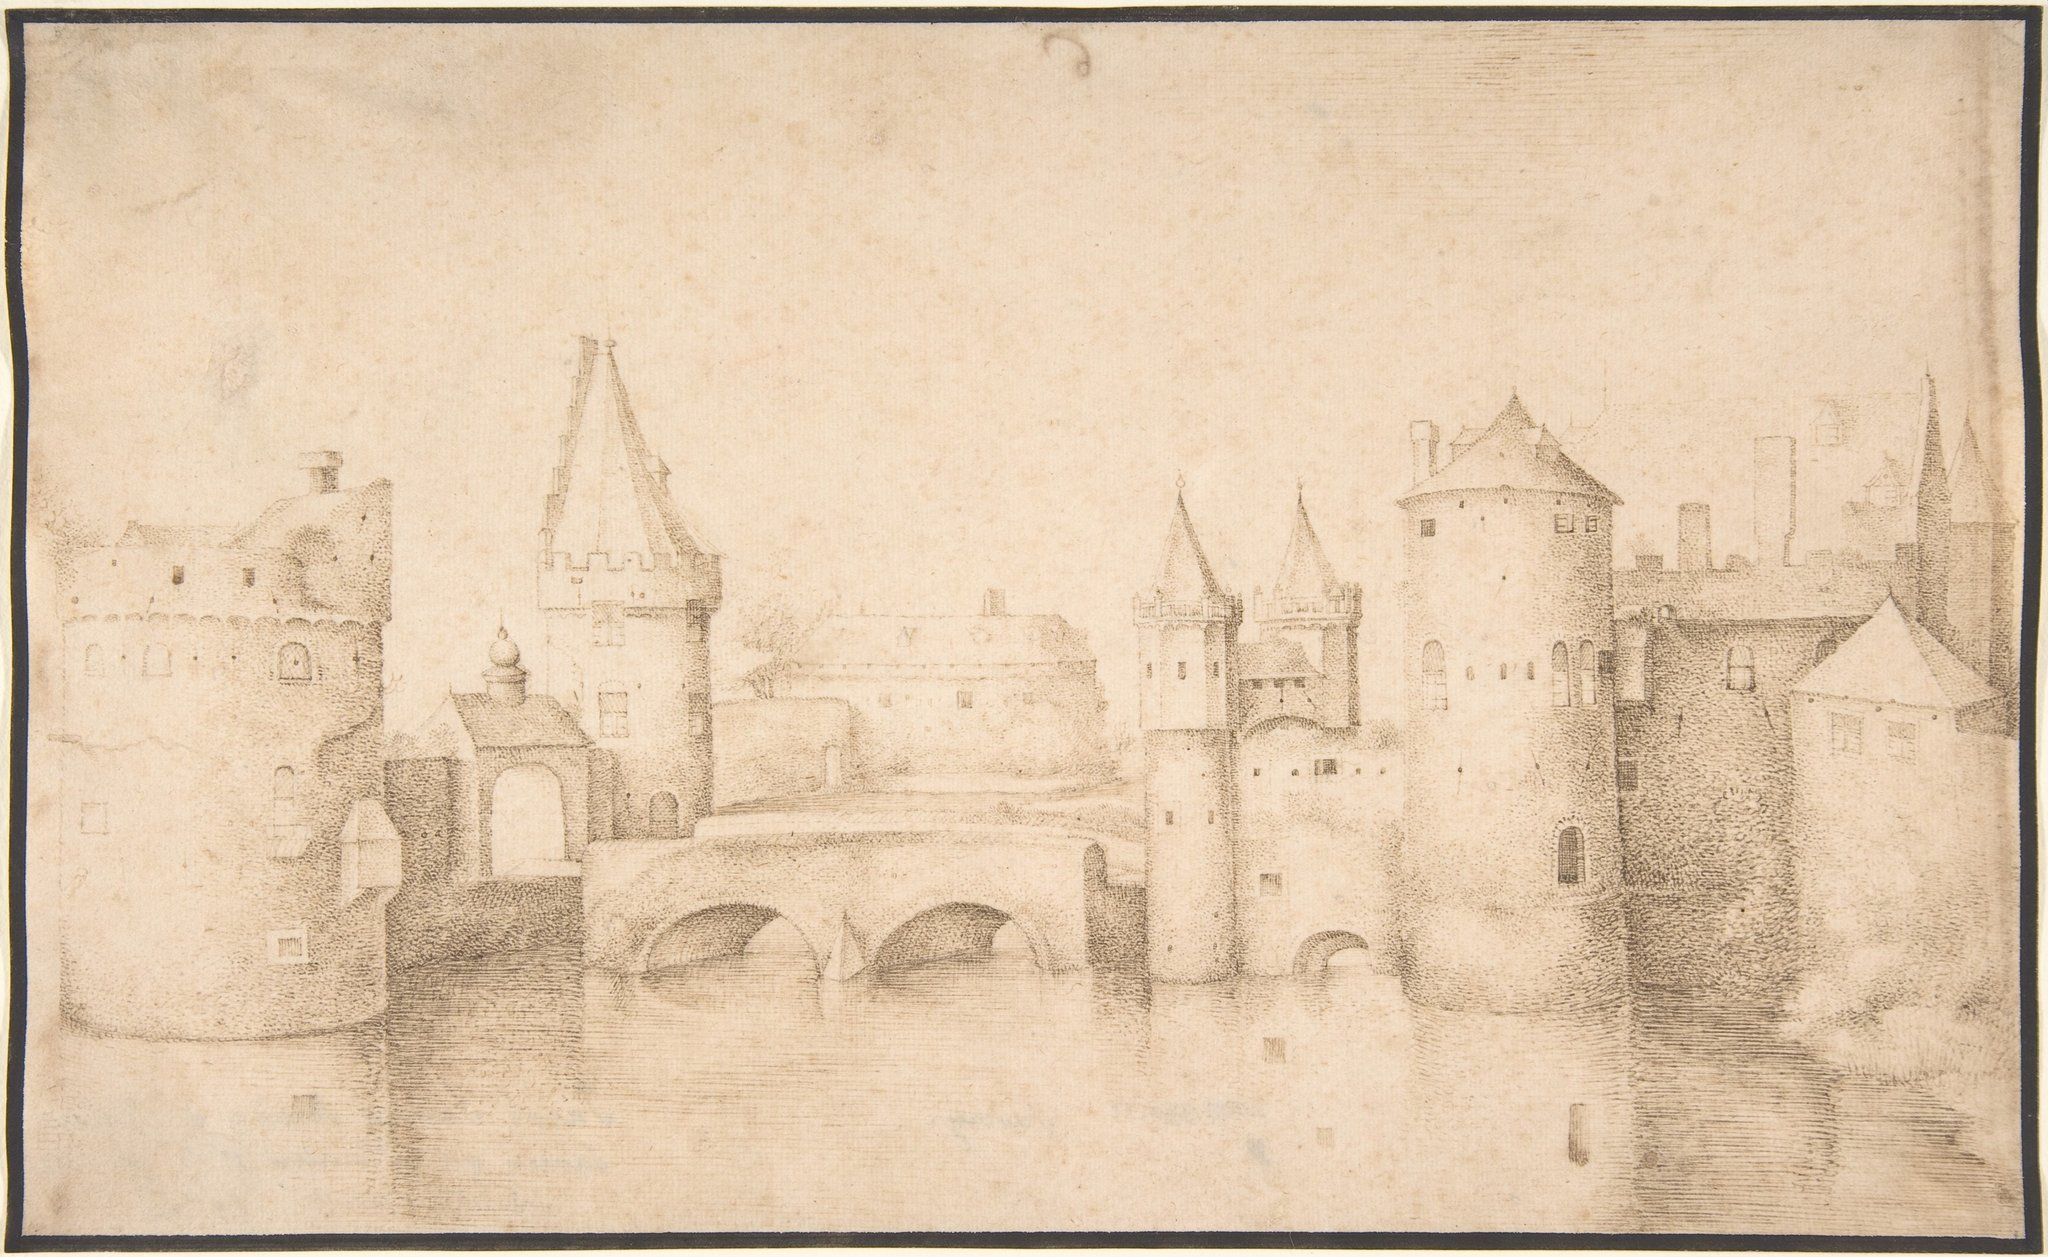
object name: drawing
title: Walls, Towers, and Gates of Amsterdam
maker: jacob savery i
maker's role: artist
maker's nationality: netherlandish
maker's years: 1565-1603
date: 1567-1633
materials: ink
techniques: pen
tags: buildings,towers,canals,amsterdam